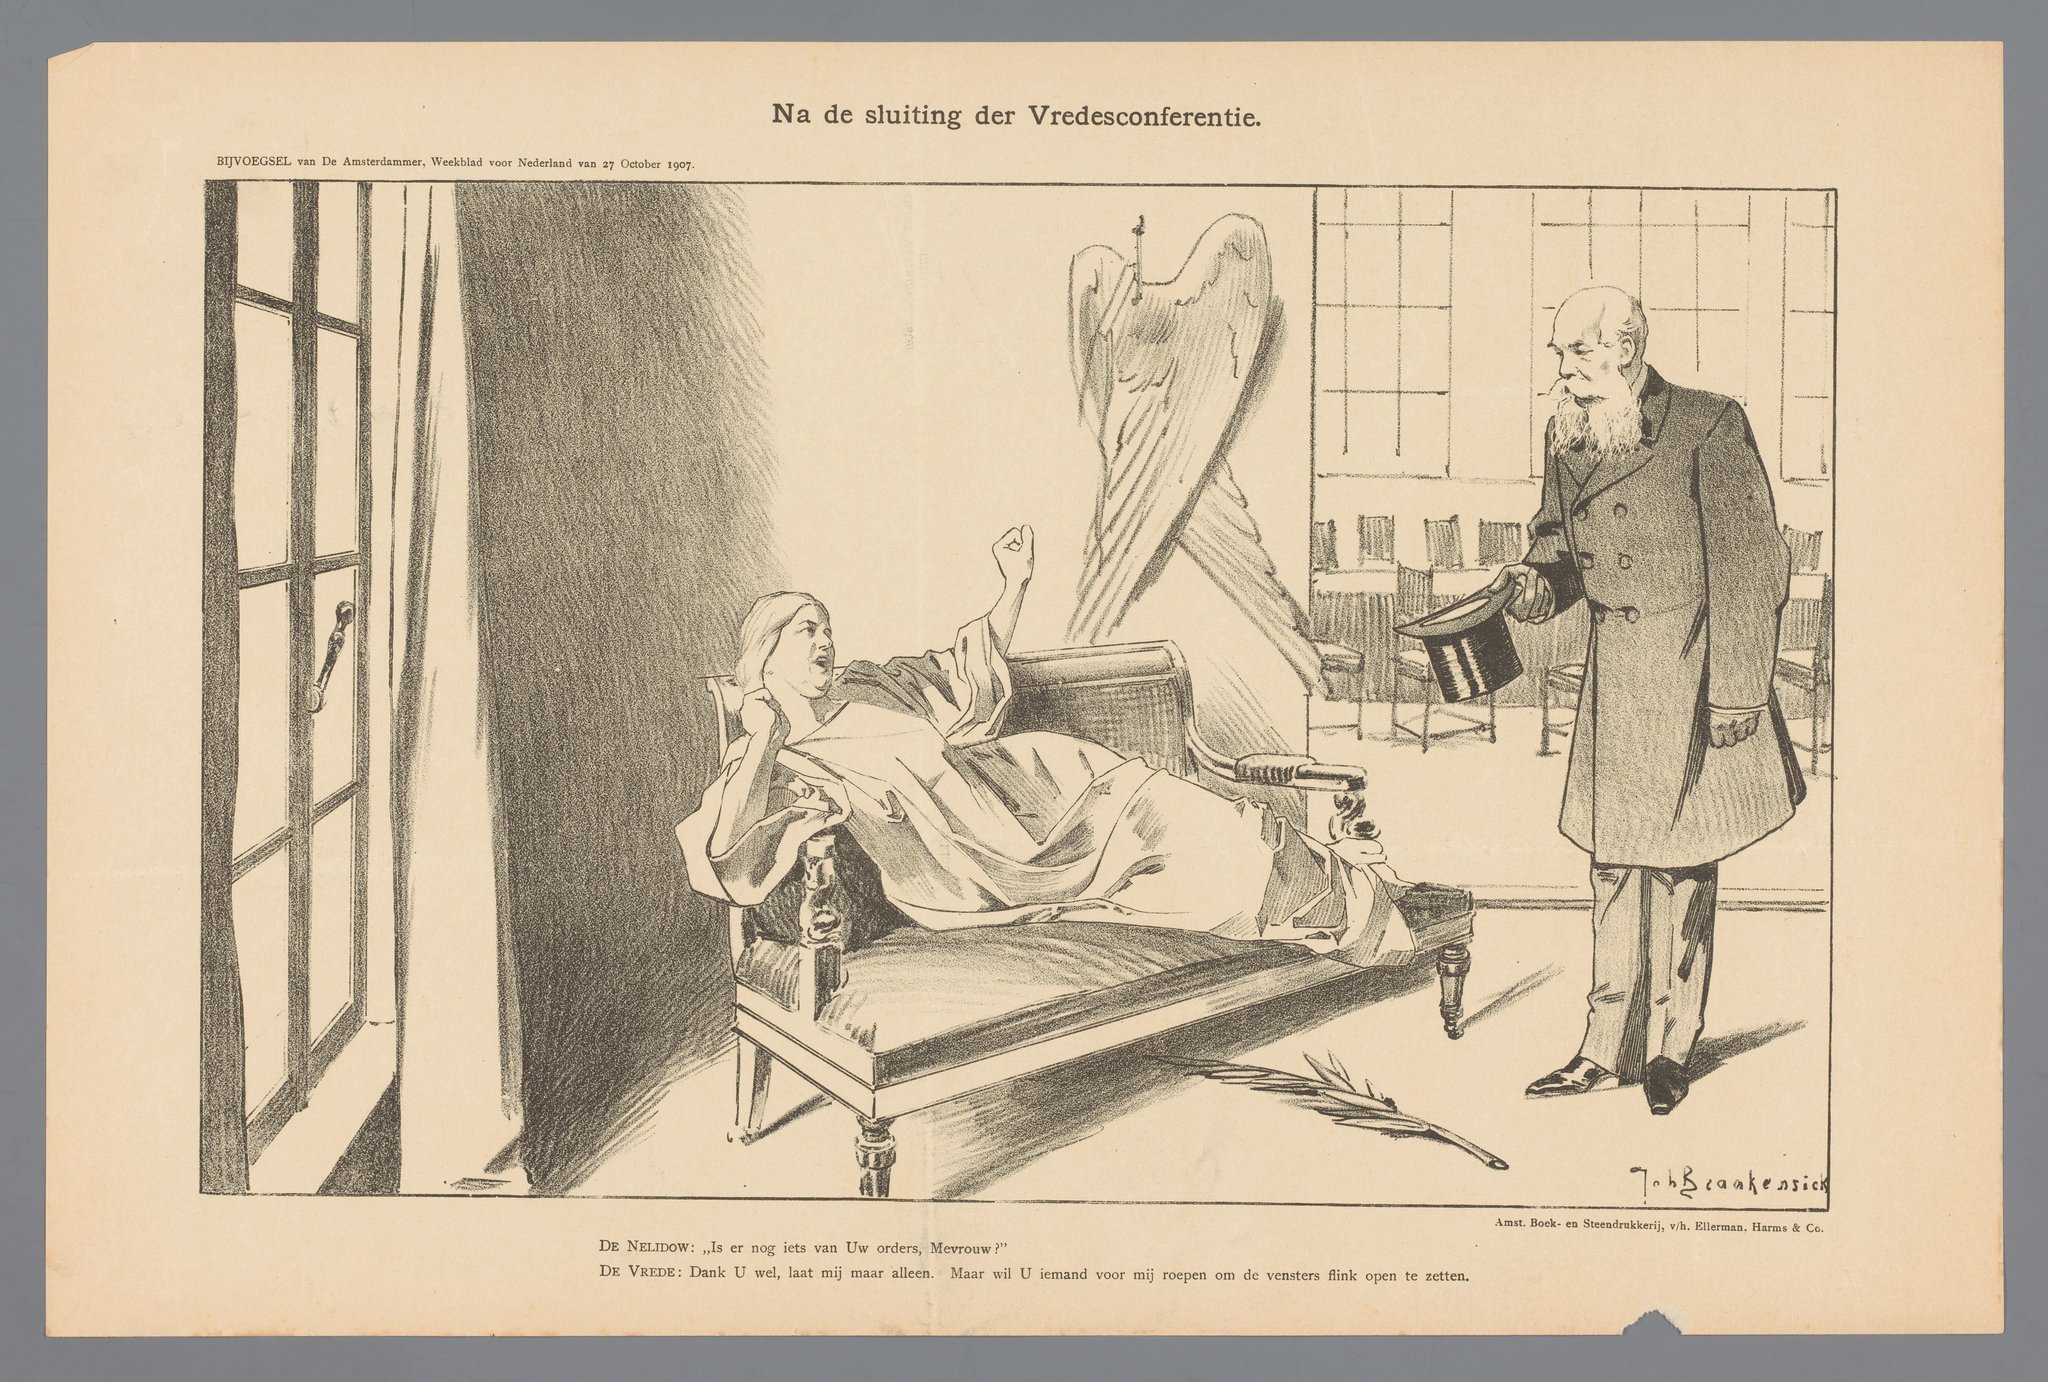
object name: cartoon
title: Na de sluiting der Vredesconferentie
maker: johan braakensiek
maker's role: draughtsman, print maker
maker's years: 1858-1940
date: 1907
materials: paper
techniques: lithograph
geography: amsterdam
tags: symbols, allegories of peace, 'pax'; 'pace' (ripa), peace, political caricatures and satires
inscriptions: date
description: Prent uit het bijvoegsel van: De Amsterdammer. Weekblad voor Nederland, 27 oktober 1907.